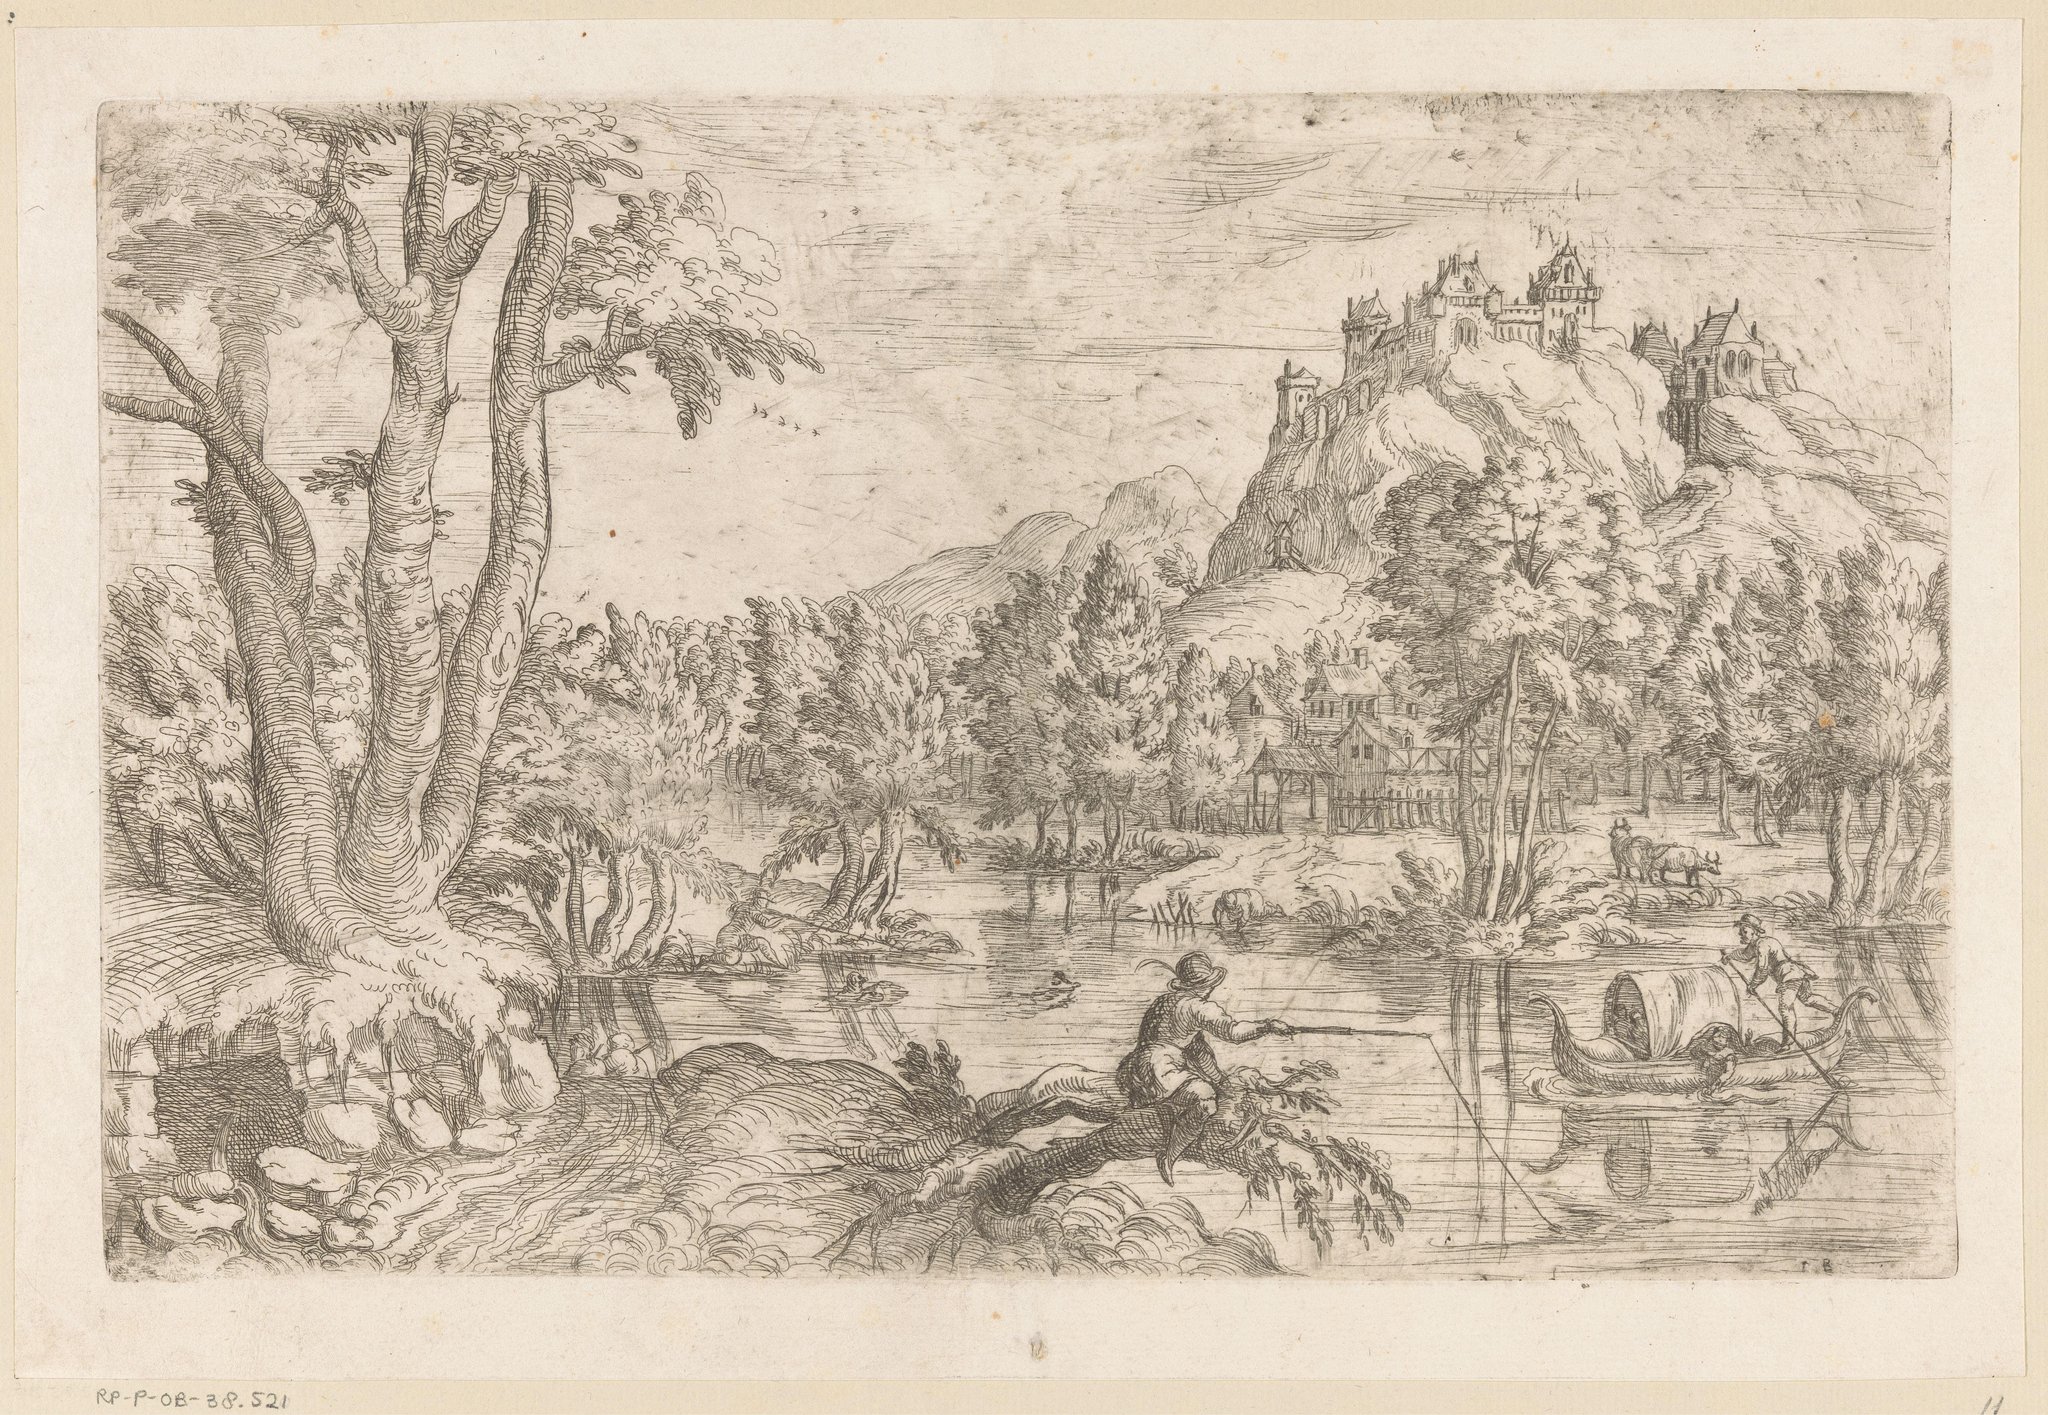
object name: print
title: Landschap met rivier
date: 1500-1599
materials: paper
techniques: etching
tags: fortress, landscapes, fisherman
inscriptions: number: ‘322’, collector's mark: Lugt 240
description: Landschap met een rivier. Op de voorgrond een visser aan de waterkant en een man varend in een gondel over het water. Op de achtergrond een fort op een heuvel.